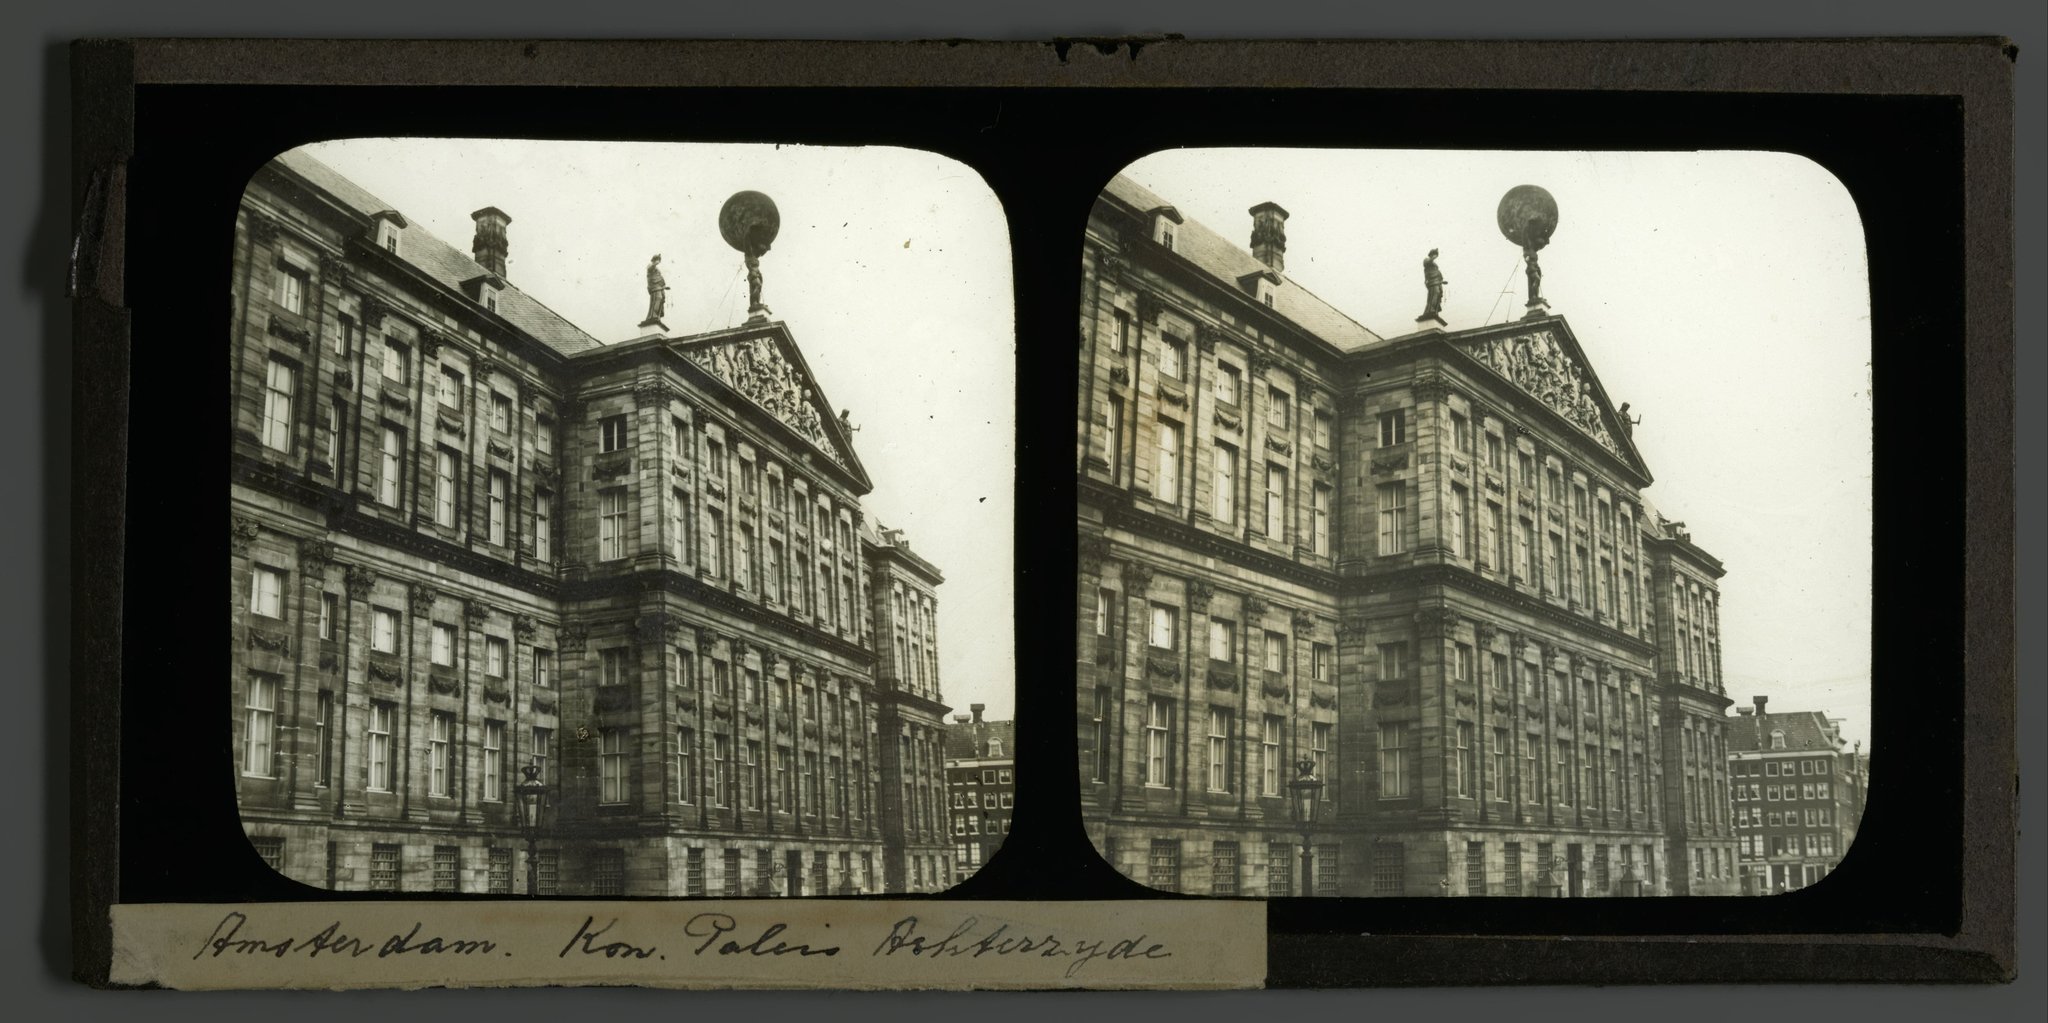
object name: stereoscopic photograph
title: Amsterdam, Kon. Paleis achterzijde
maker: Anonymous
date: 1860-1890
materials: glass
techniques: slide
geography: amsterdam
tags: palace, royal palace of amsterdam